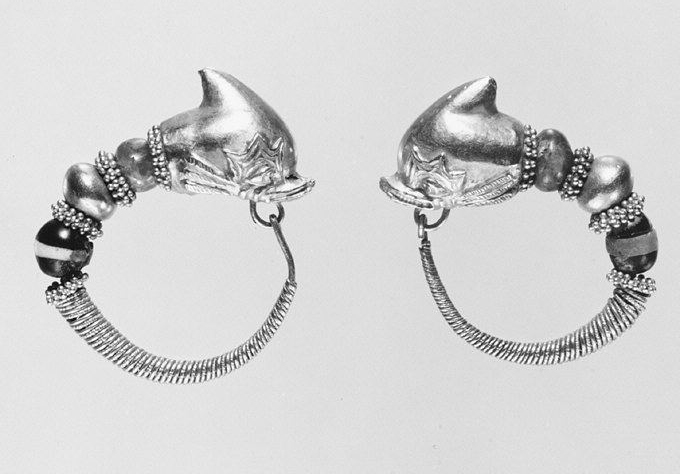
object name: earring with head of dolphin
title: Pair of gold earrings with dolphins' heads with emerald, glass, and gold beads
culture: greek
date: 200-1 BCE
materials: gemstone, glass, gold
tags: dolphins